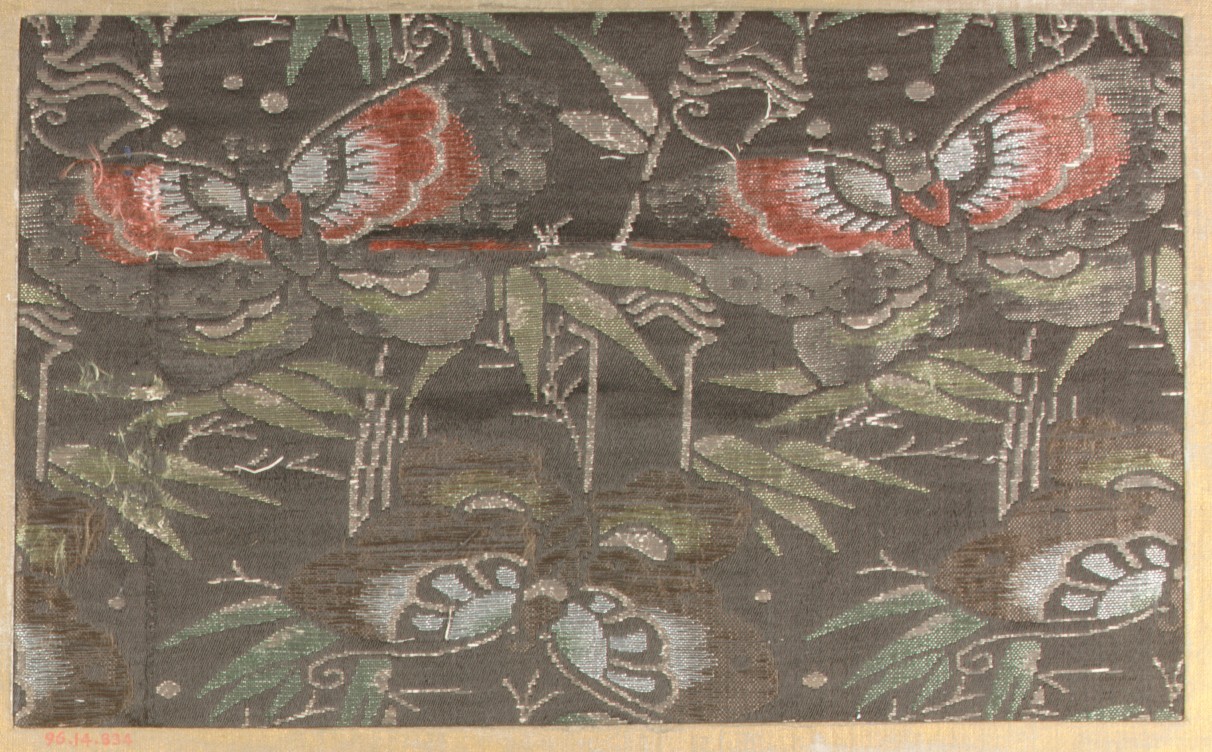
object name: piece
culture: japanese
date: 1701-1900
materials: silk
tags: butterflies,leaves